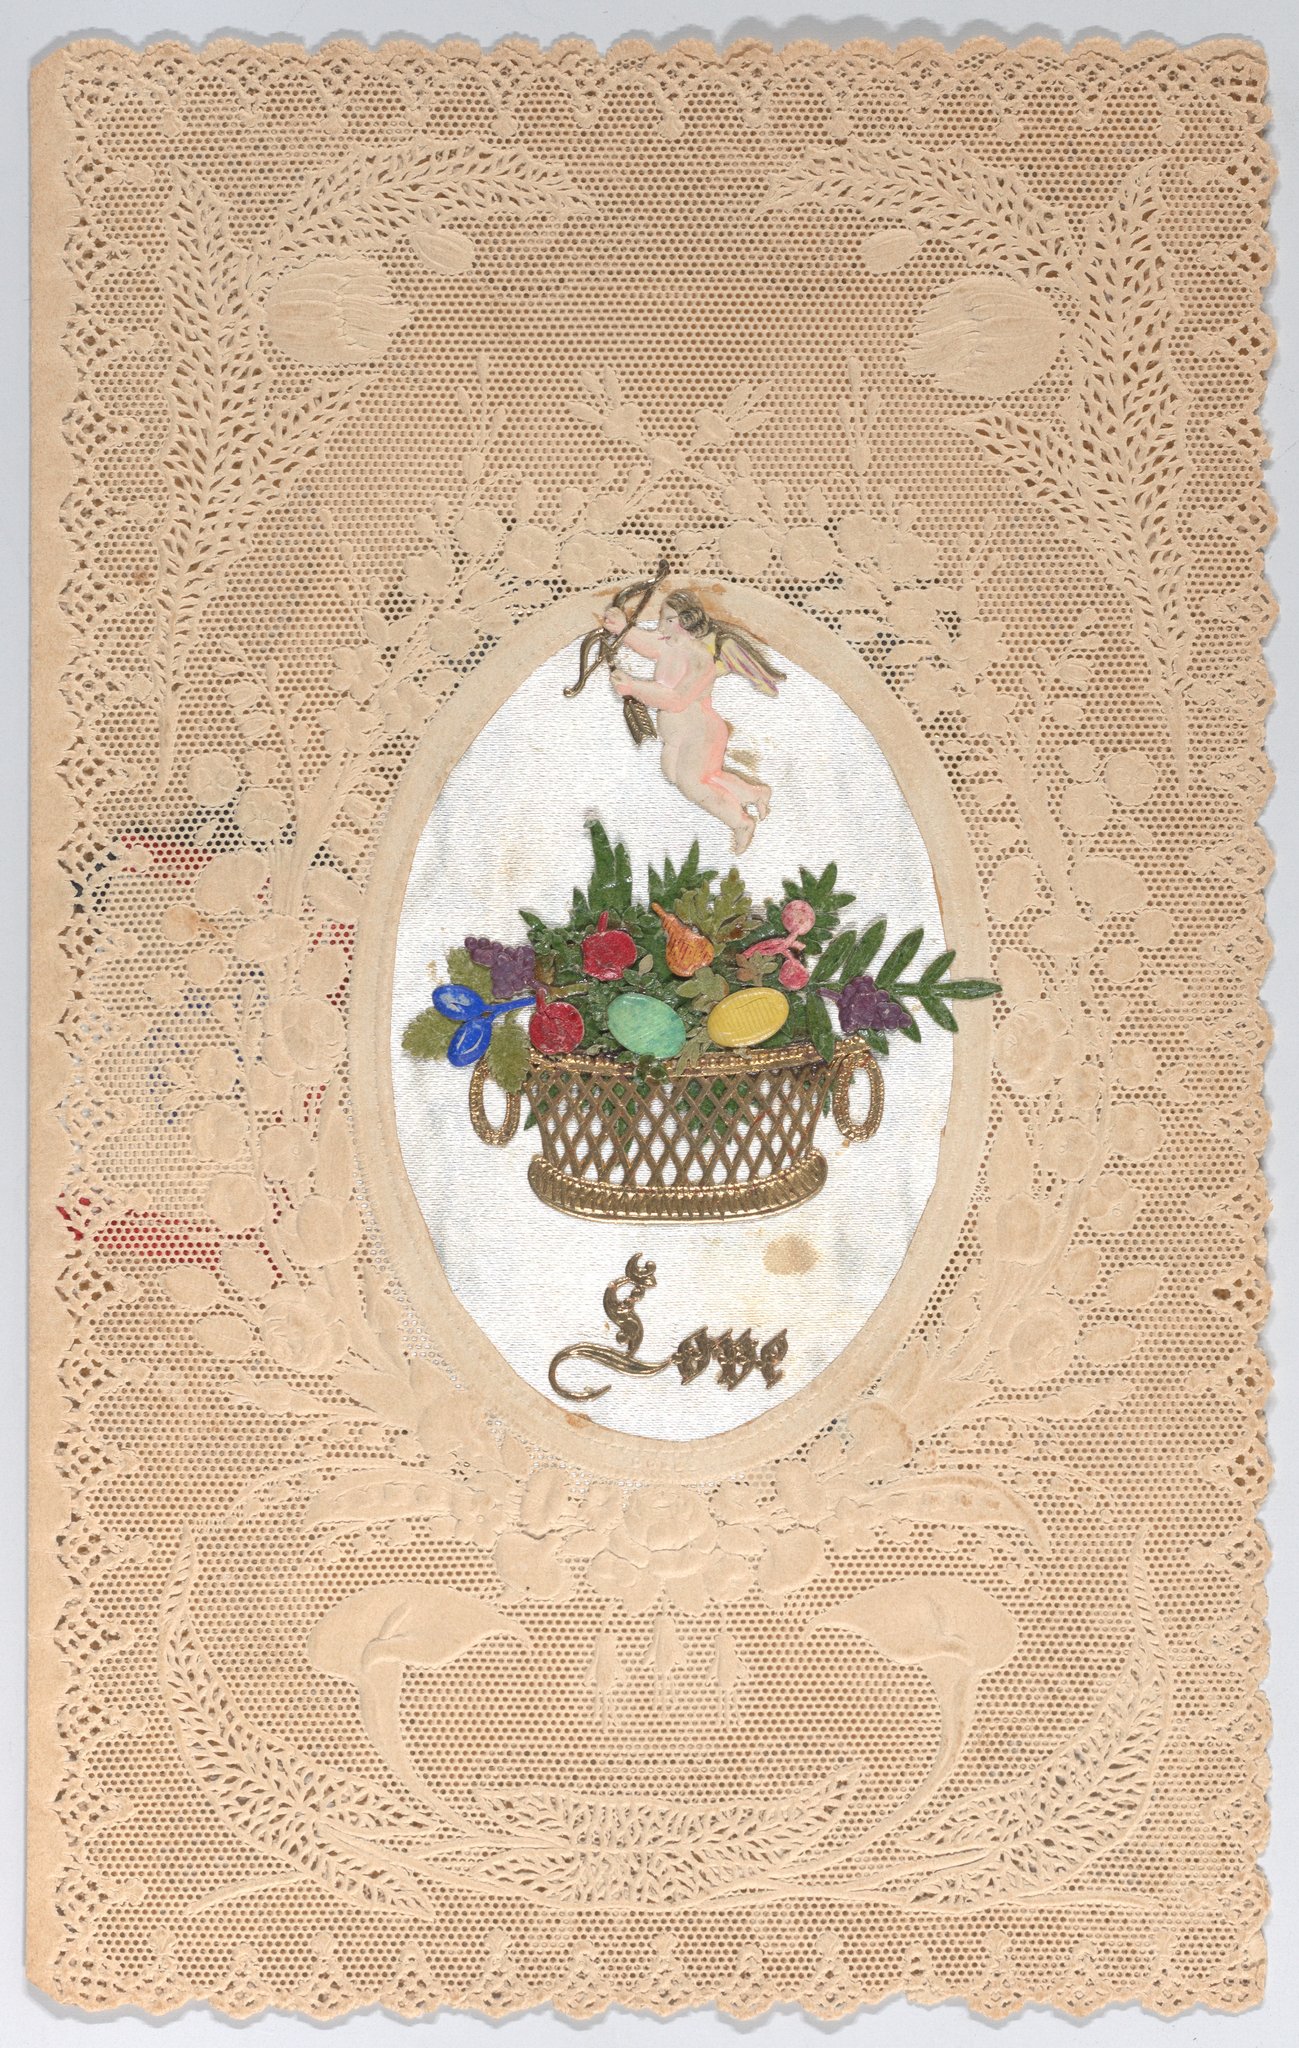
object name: valentine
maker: Anonymous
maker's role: artist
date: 1850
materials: gilt, lace, paper, watercolor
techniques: chromolithography, cutting, embossing, open work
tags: flowers